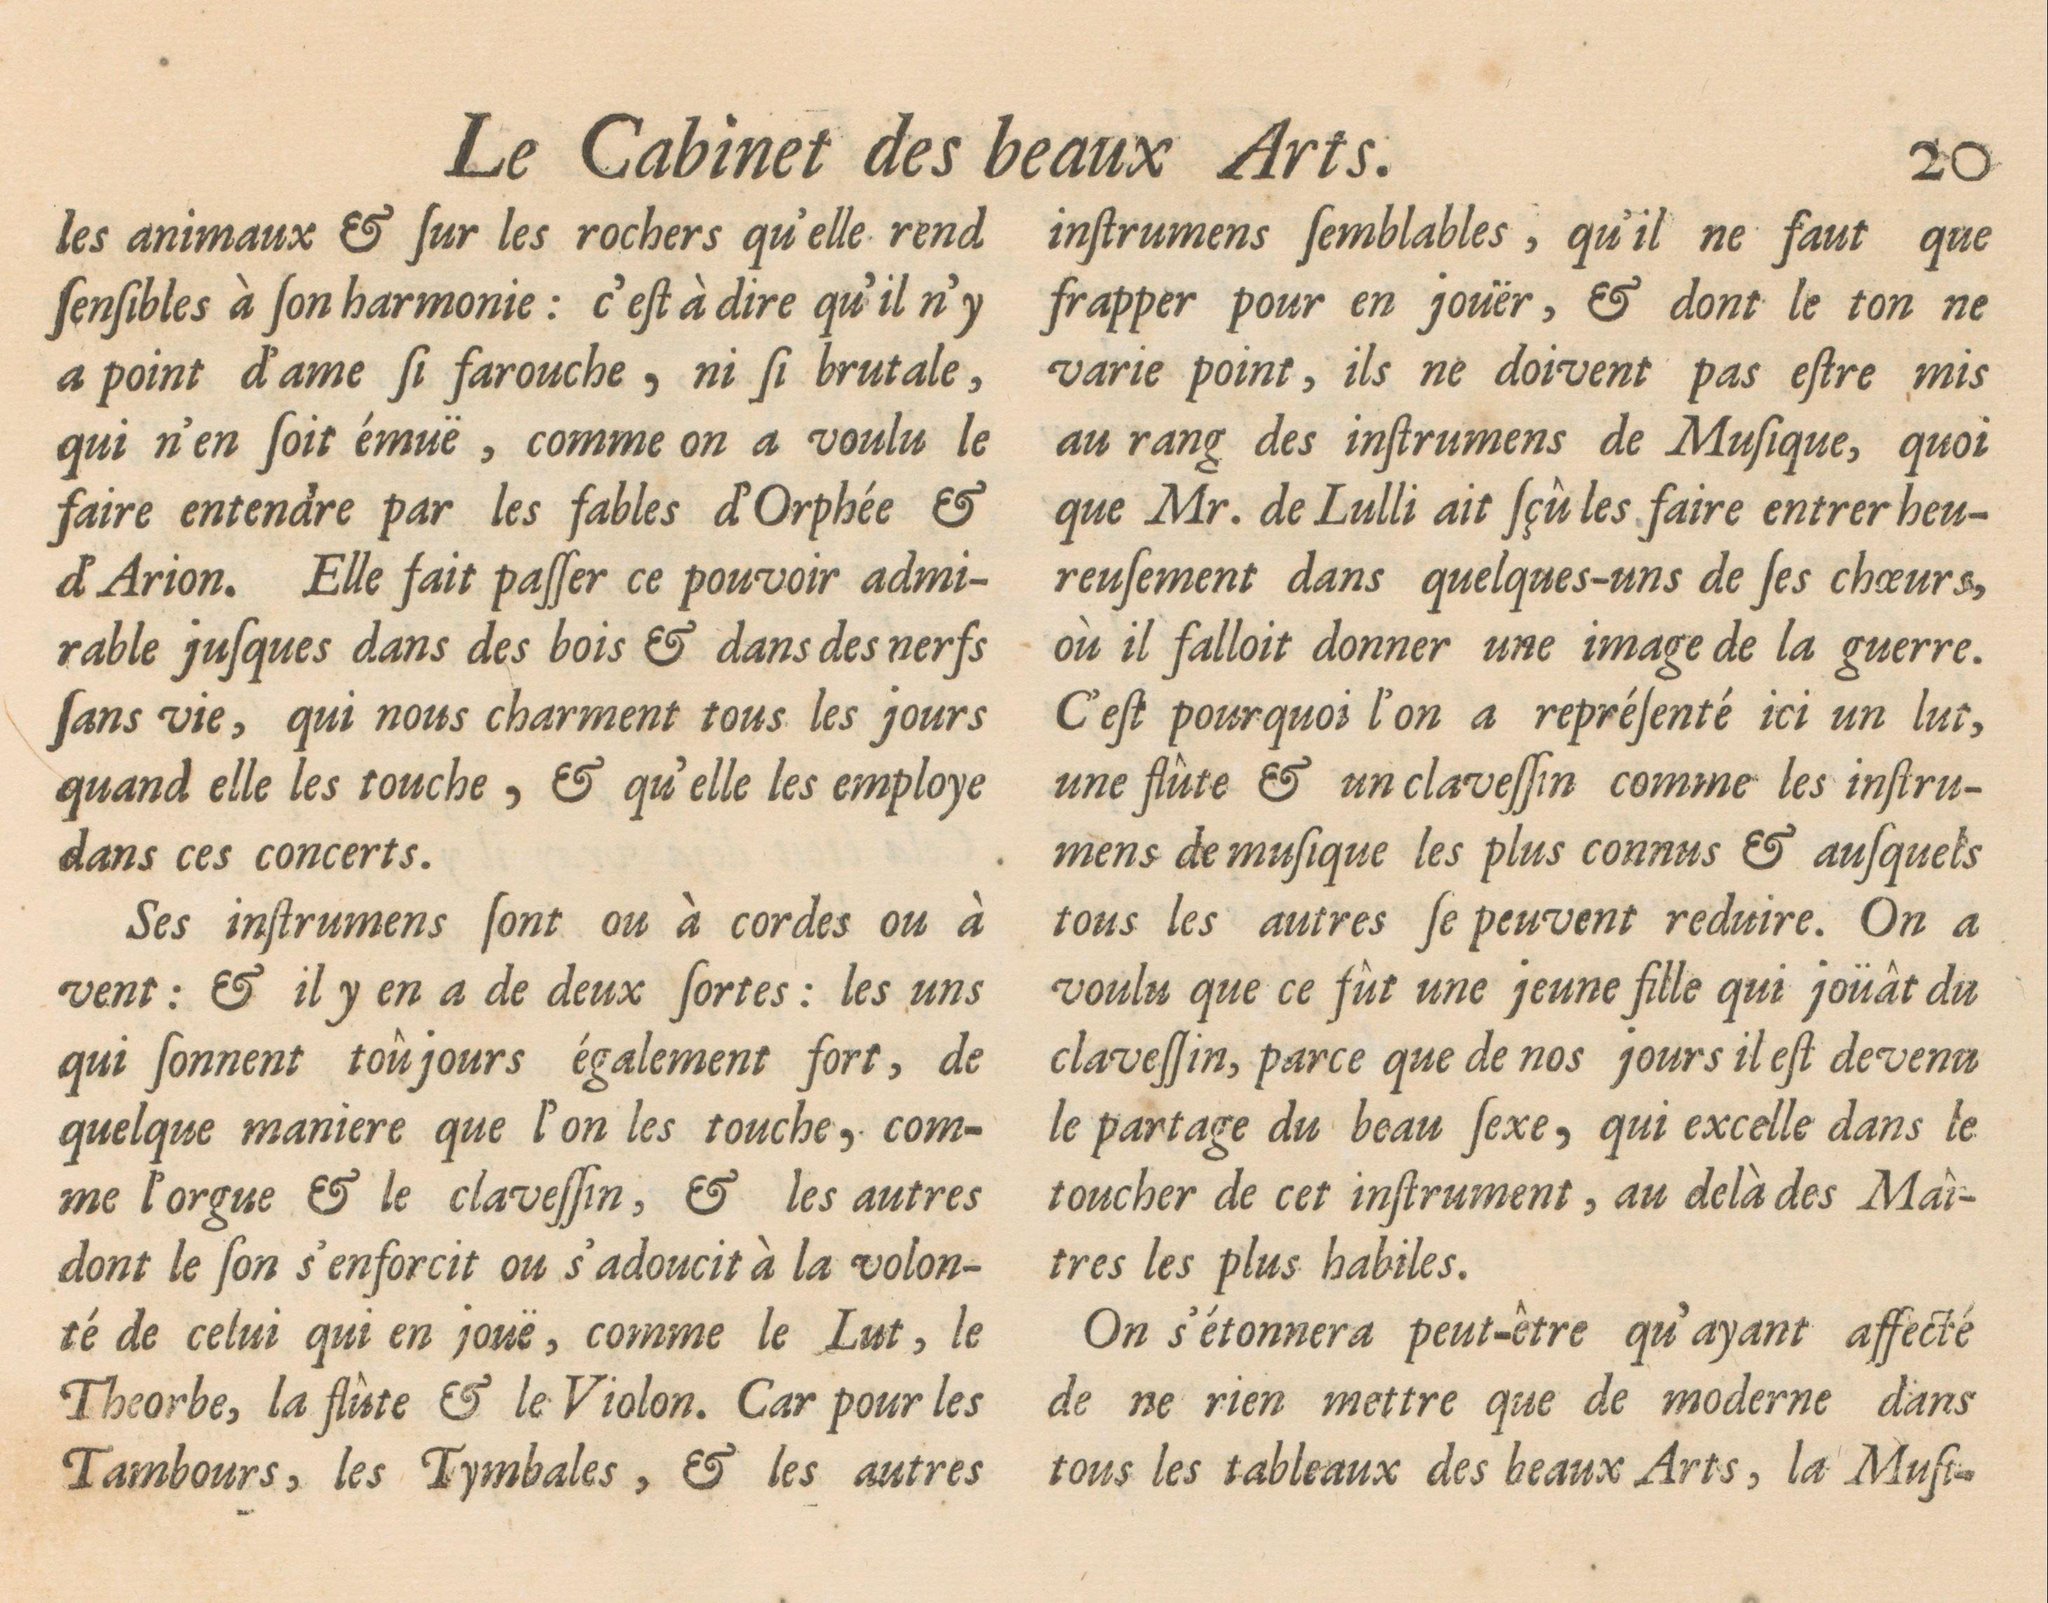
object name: text sheet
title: Tekstblad met verklaring van de prent over Muziek, p. 20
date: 1695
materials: paper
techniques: letterpress printing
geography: paris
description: Verklaring van de prent met voorstelling van Muziek in het Frans. Pagina 20. Tekstblad maakt deel uit van een album.